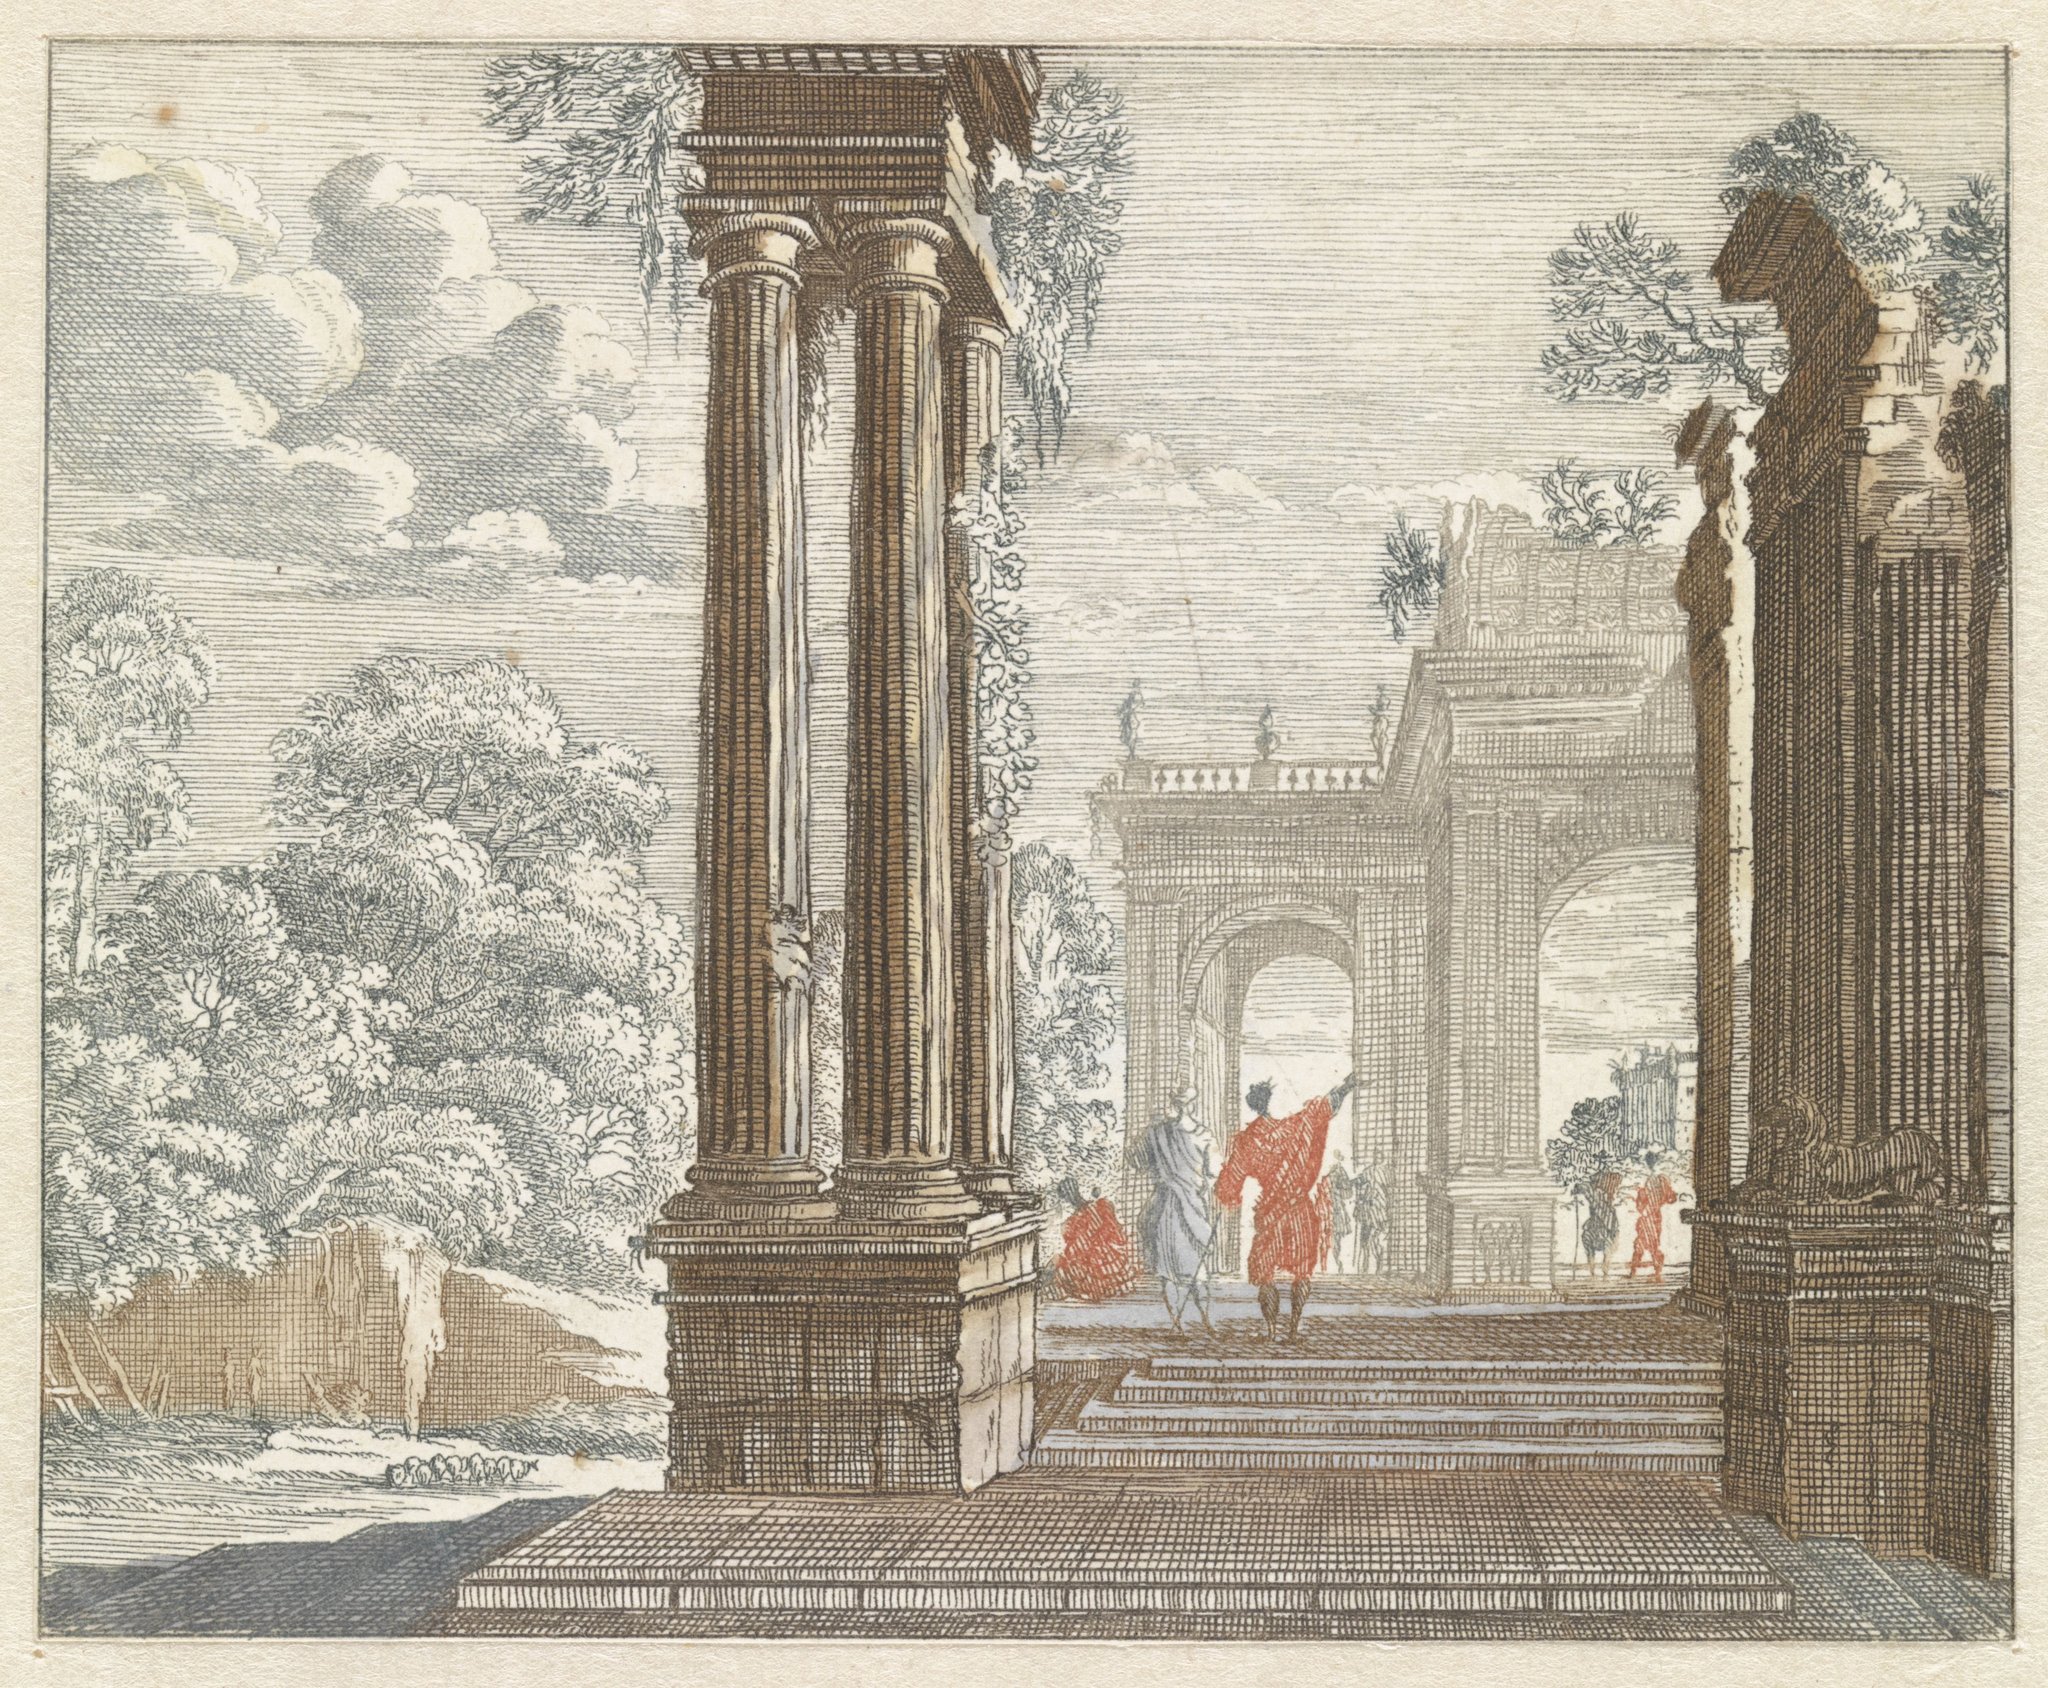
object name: print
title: Landschap met begroeide Romeinse ruïnes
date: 1688-1698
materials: paper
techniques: etching, hand coloring, lithography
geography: netherlands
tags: landscape with ruins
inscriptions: collector's mark: Lugt 2228, collector's mark: Lugt 2760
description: Landschap met midden op de voorgrond drie zuilen op een basement. Figuren bewonderen de achterliggende ruïne.